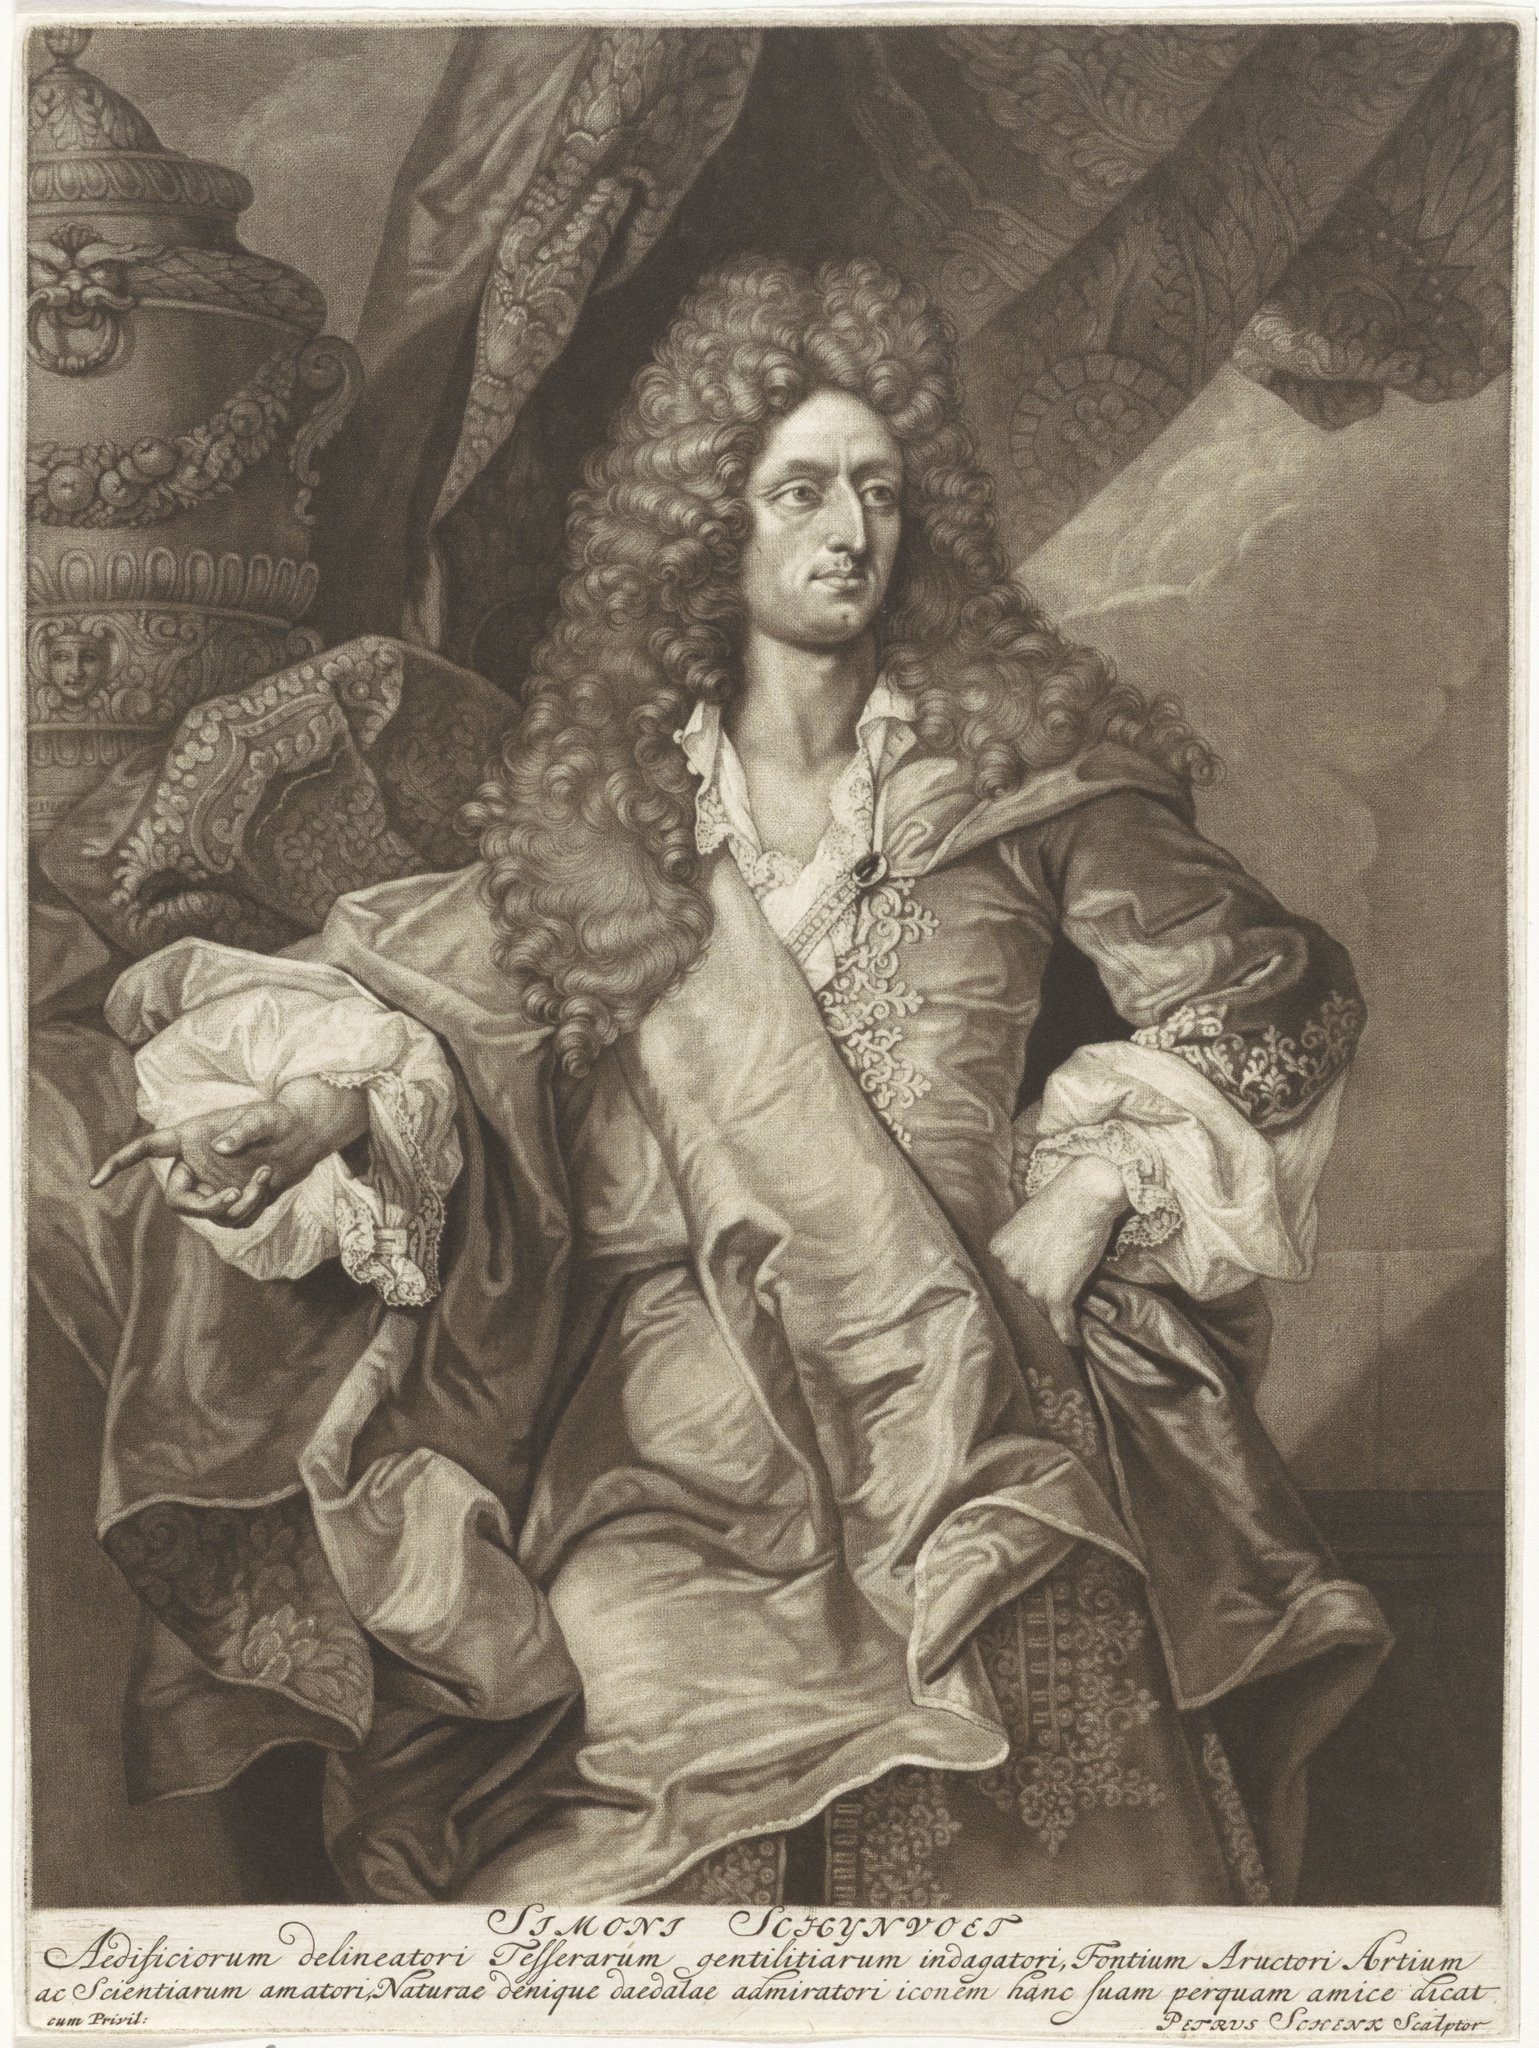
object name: print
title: Portret van Simon Schijnvoet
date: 1670-1713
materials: paper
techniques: engraving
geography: amsterdam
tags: the hague, simon schijnvoet, wig, urn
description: De architect Simon Schijnvoet wijst met zijn rechterhand. Achter hem een grote vaas, een draperie en wolken.